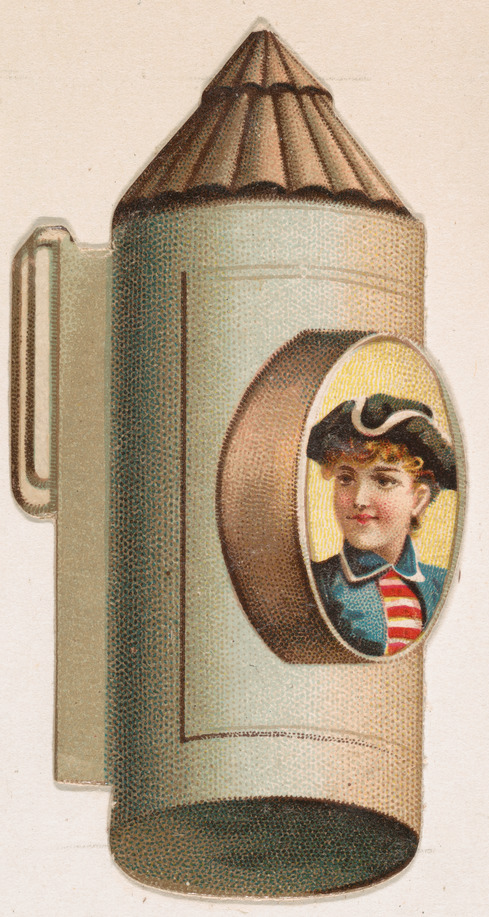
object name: print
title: Lantern, from the Novelties series (N228, Type 3) issued by Kinney Bros.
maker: kinney brothers tobacco company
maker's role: publisher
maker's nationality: american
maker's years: 1869-2011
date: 1889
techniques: color lithograph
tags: women,lanterns